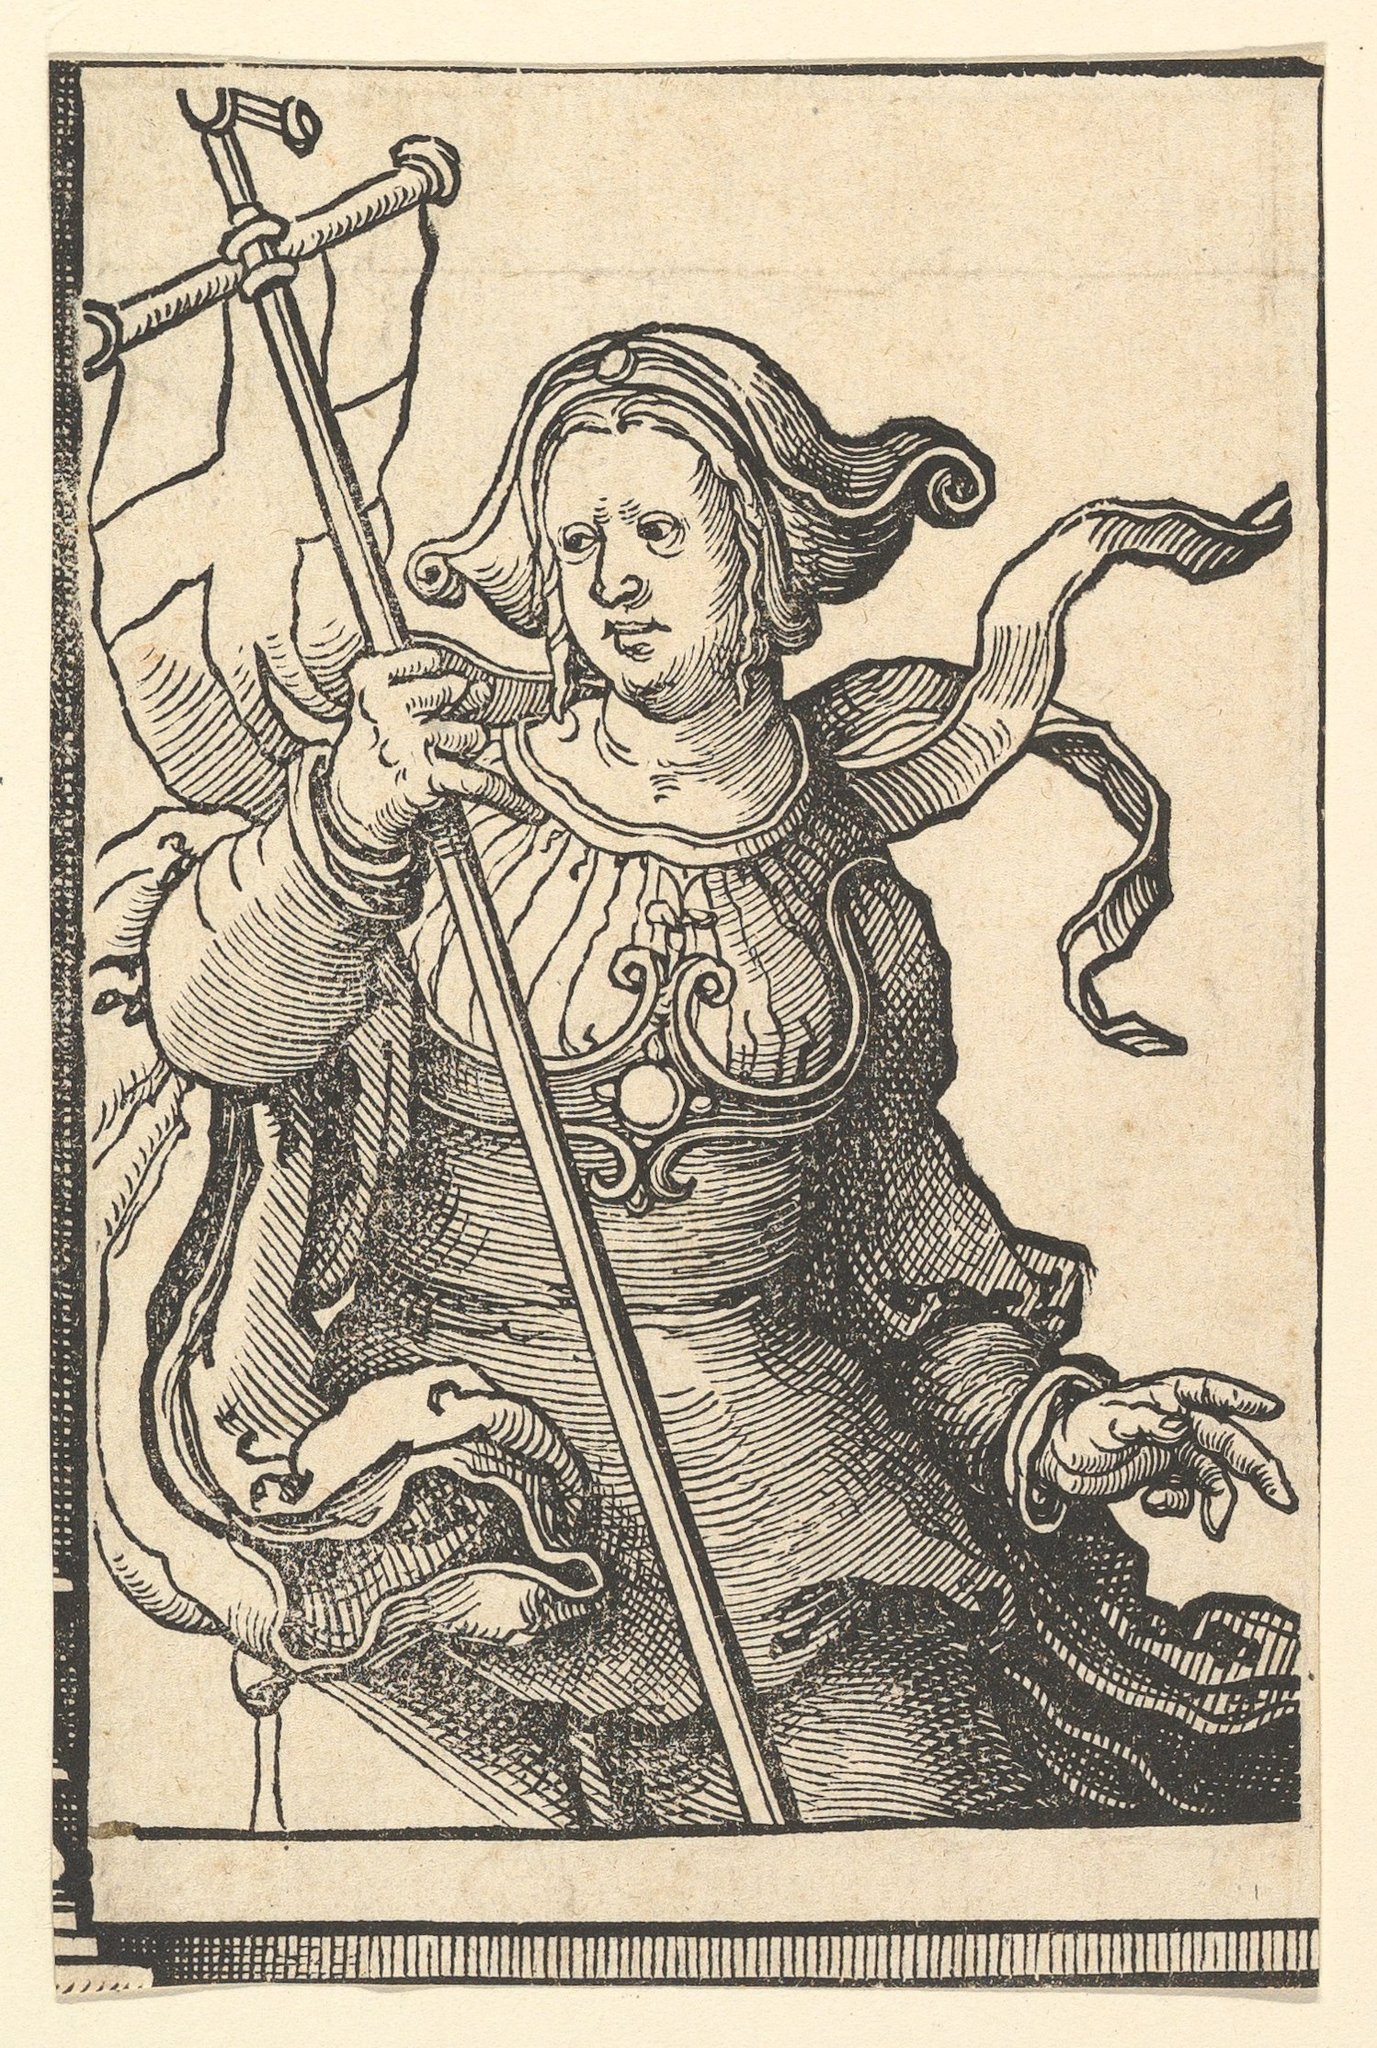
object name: print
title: Phrygian Sibyl, from the series of Sibyls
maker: lucas van leyden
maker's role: artist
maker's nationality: netherlandish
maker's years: 1494-1533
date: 1530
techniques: woodcut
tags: sibyl